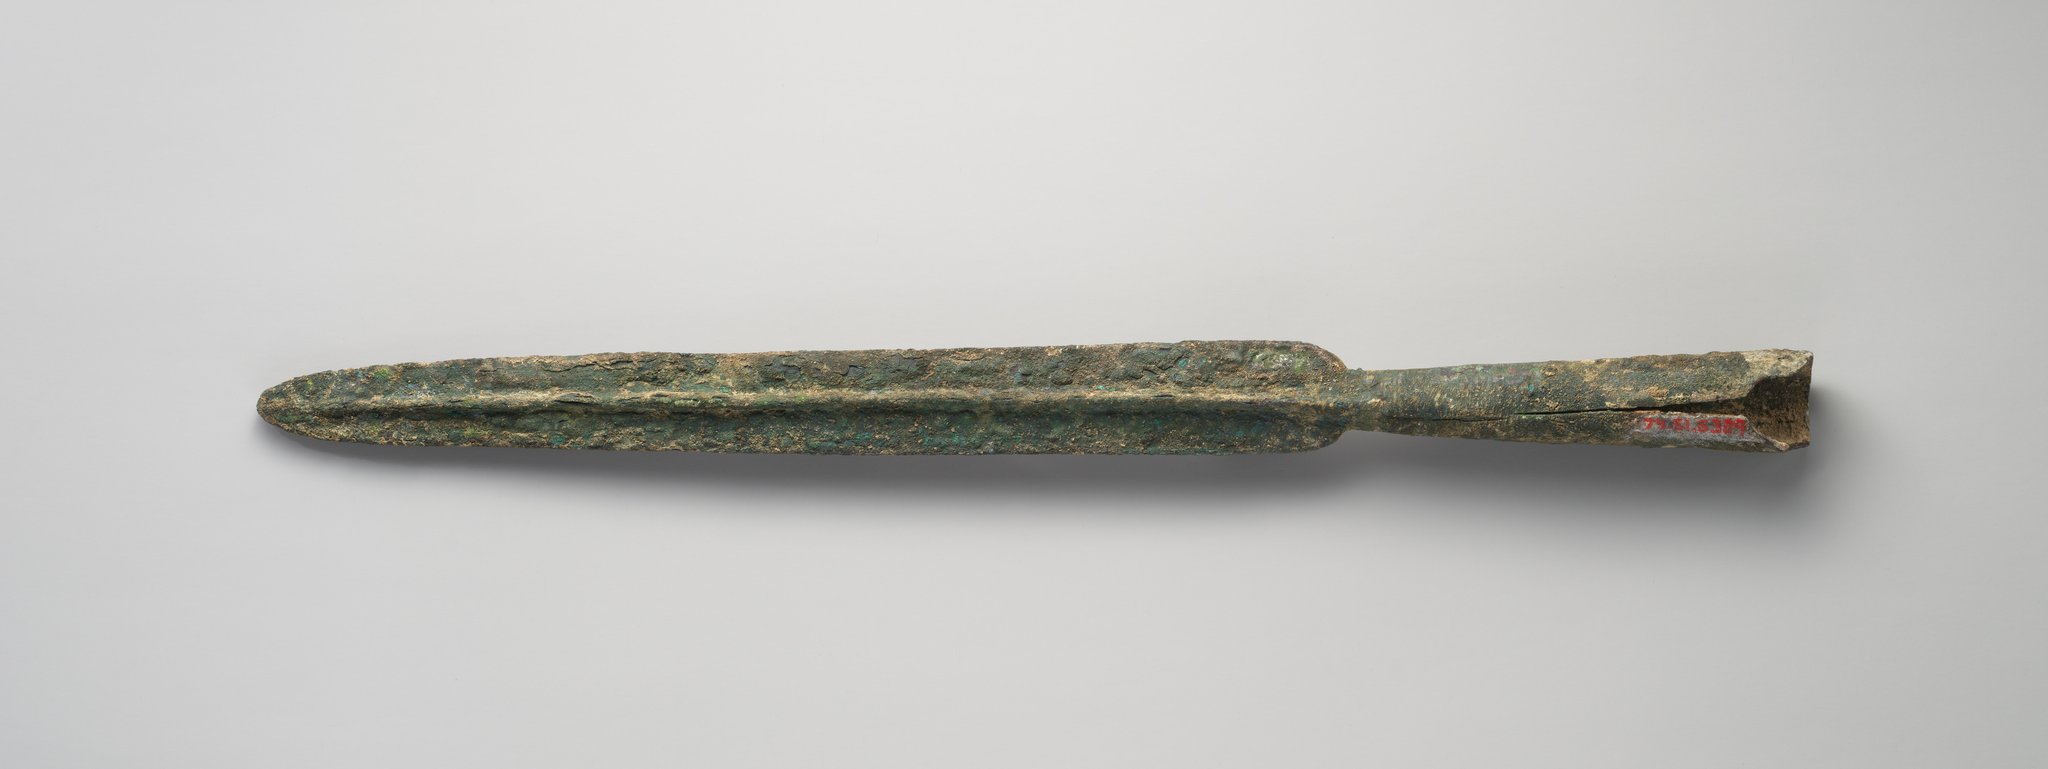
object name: spearhead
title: Bronze spearhead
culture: cypriot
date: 1200-1100 BCE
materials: bronze